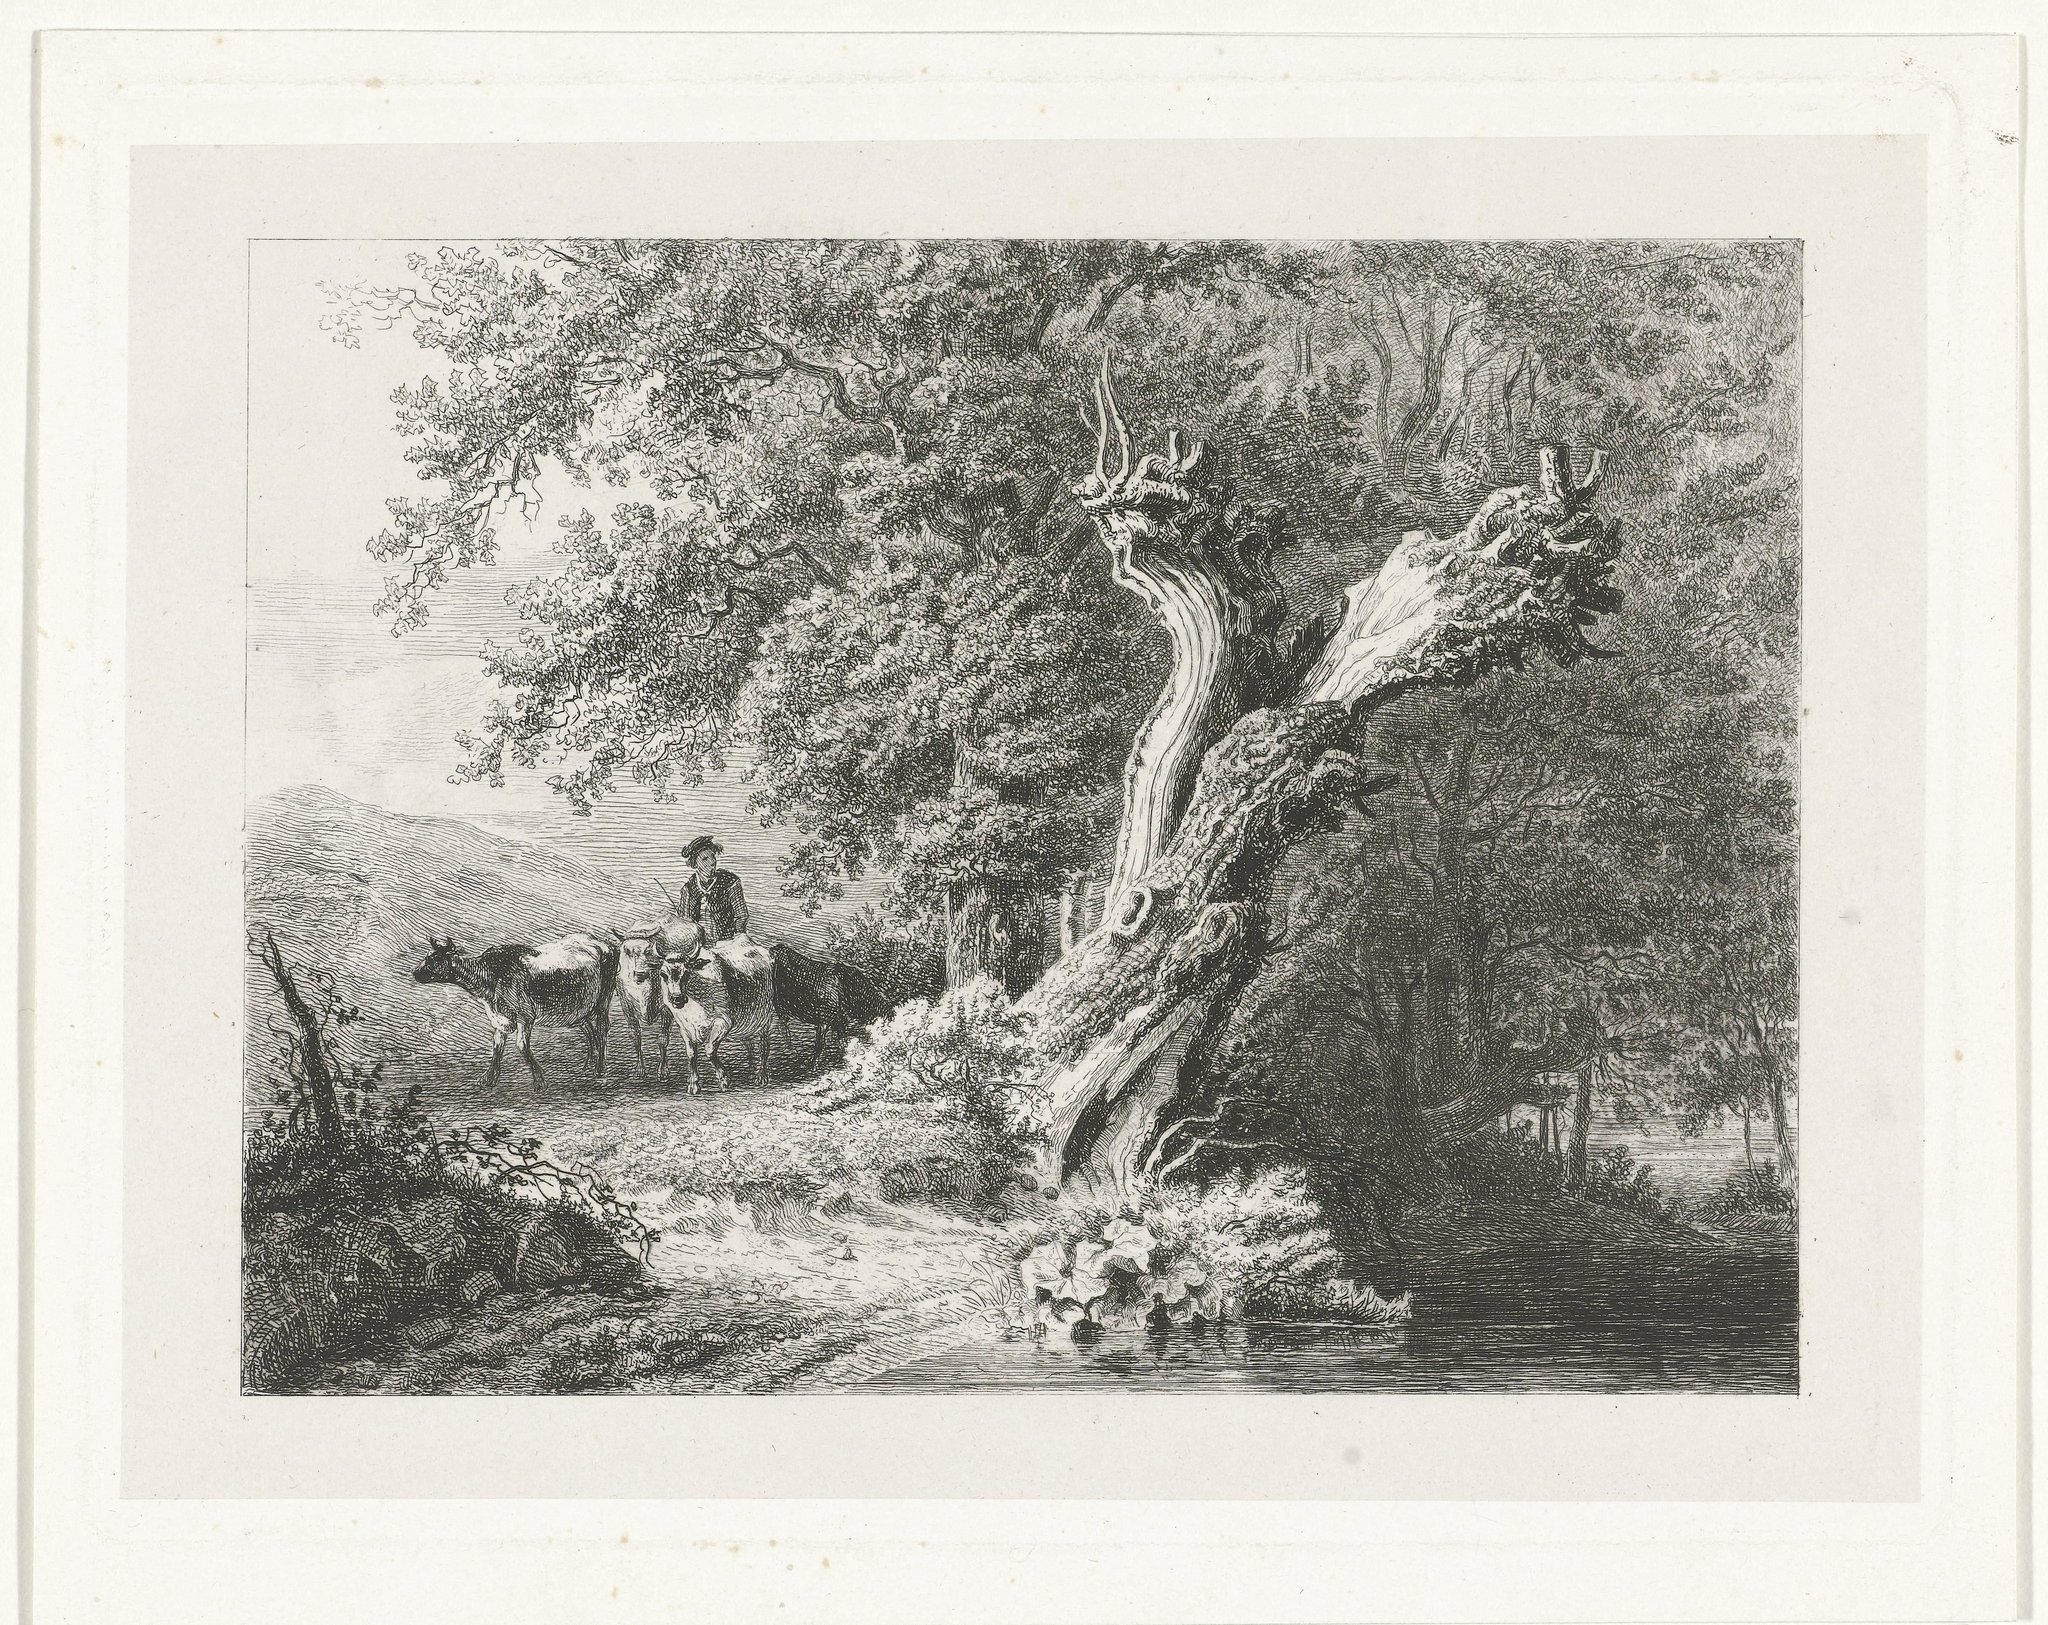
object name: print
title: Landschap met kale boom en herder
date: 1820-1886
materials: paper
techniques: etching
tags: trees, herding, herdsman, herdswoman, shepherd, shepherdess, cowherd, etc., water course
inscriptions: collector's mark: Lugt 2228, collector's mark: Lugt 698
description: Links een herder met koeien, rechts een kale boom aan het water.